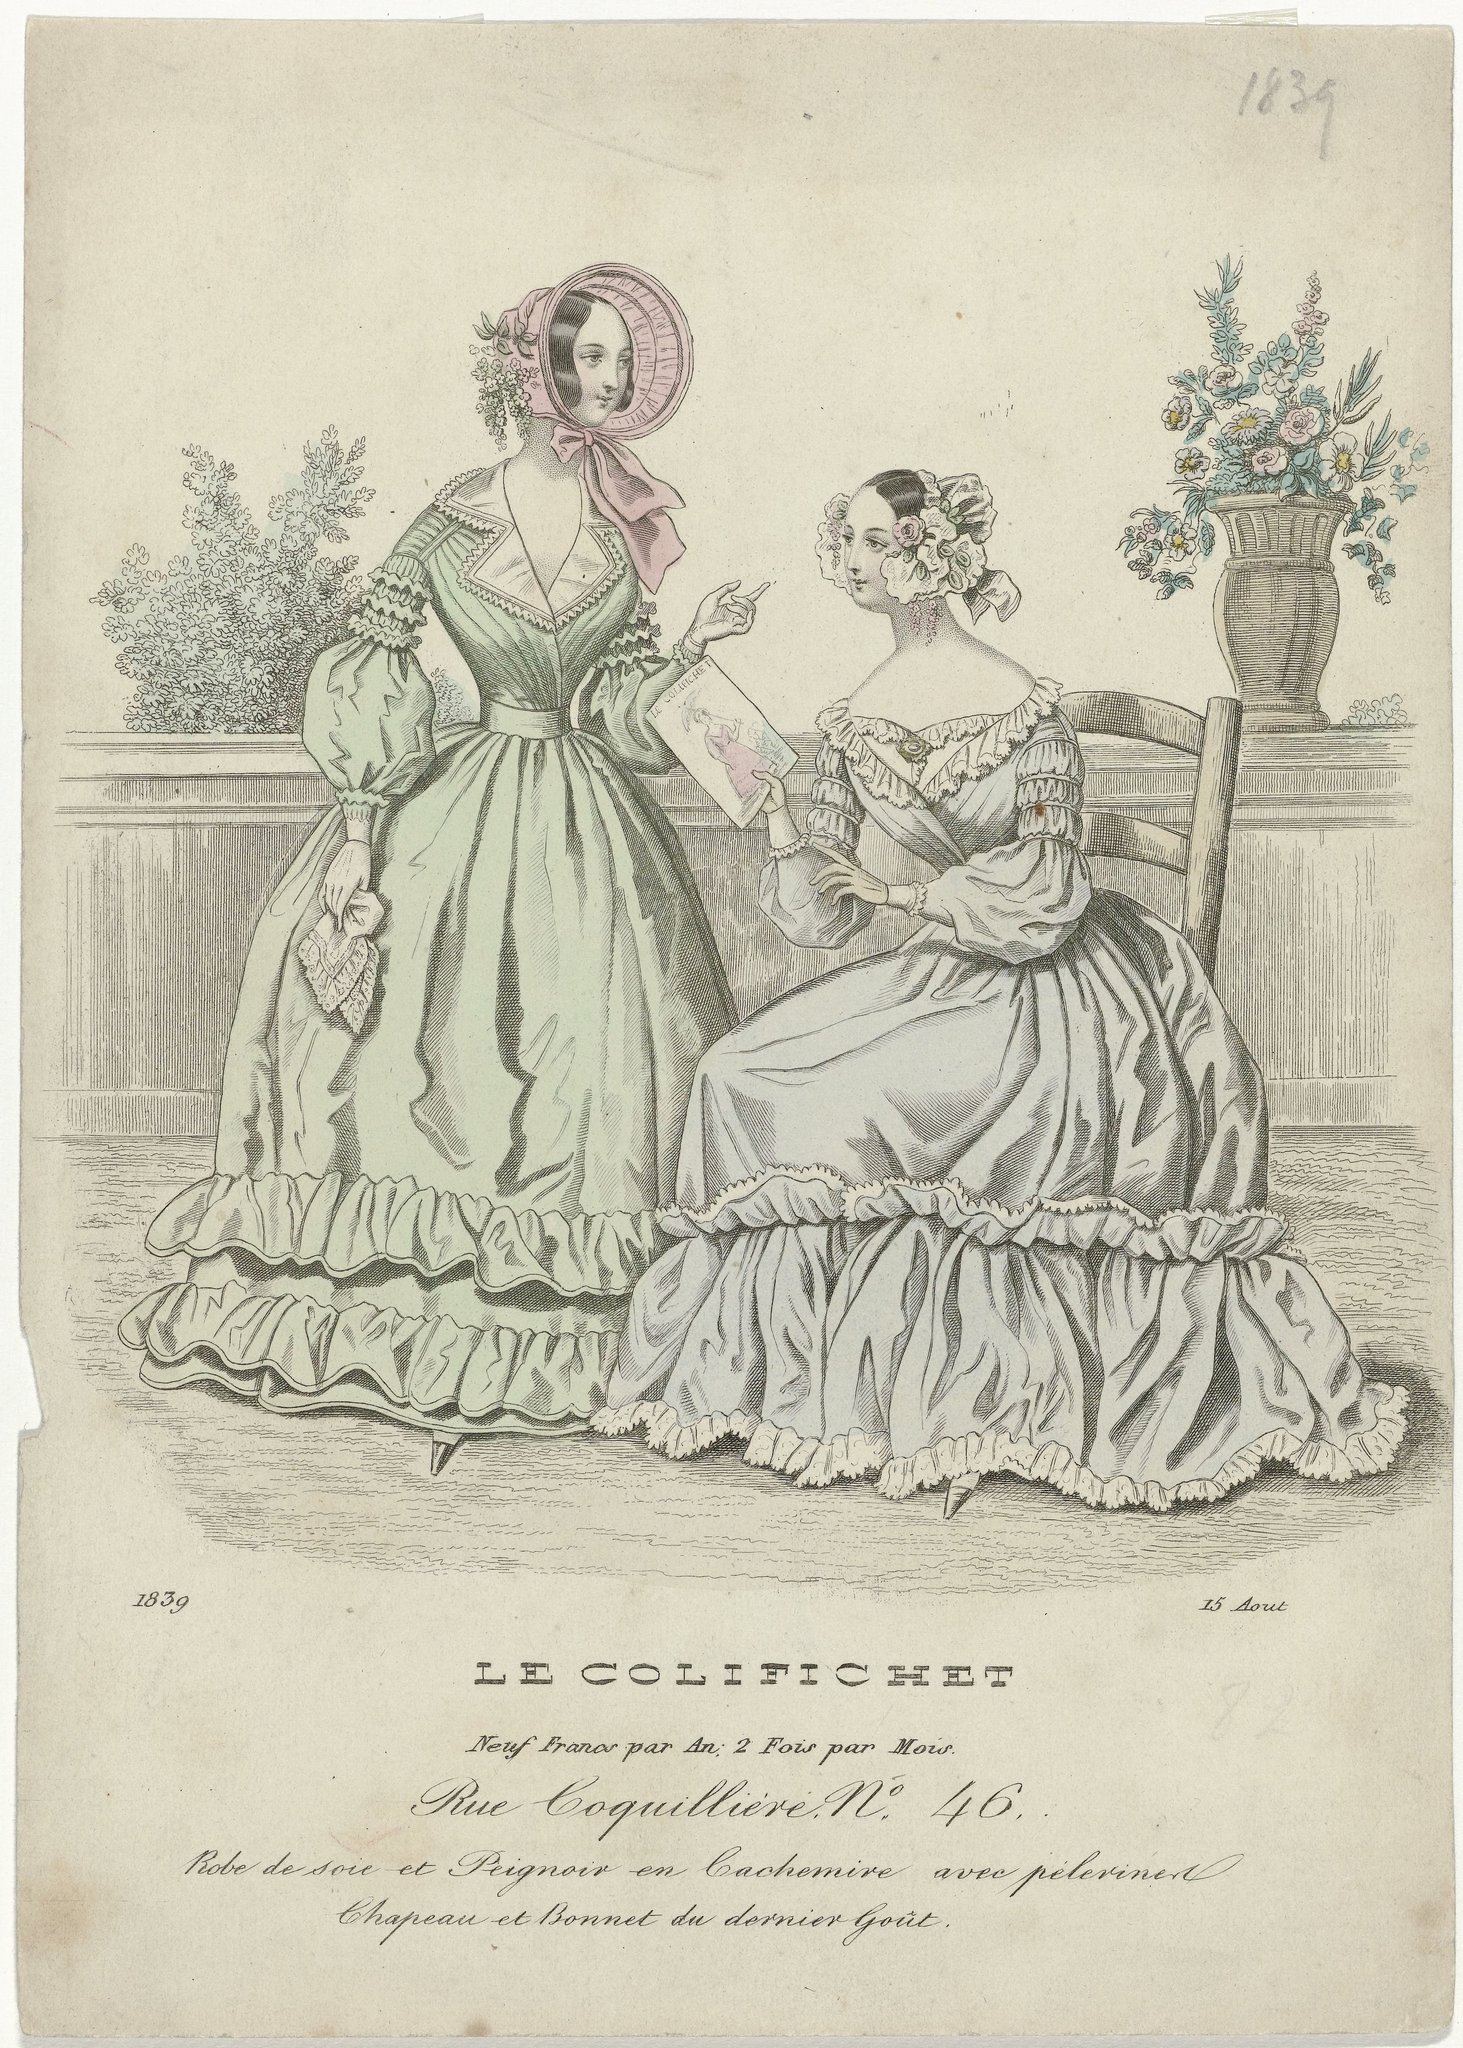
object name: fashion print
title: Le Colifichet, 15 août 1839 : Robe de soie et Peignoior (...)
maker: Anonymous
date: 1839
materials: paper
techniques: engraving, hand coloring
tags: handkerchief (+ women's clothes), brooch, agraffe, clasp (+ women's clothes), clothing for the upper part of the body (pelerine) (+ women's clothes), book in which illustrations are essential, coat (housecoat) (+ women's clothes), head-gear: cap (+ women's clothes), fashion plates, head-gear: hat (+ women's clothes), shoes, sandals (+ women's clothes), gloves, mittens, etc. (+ women's clothes), dress, gown (+ women's clothes)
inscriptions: address: ‘Rue Coquilliére, No. 46.’, title: ‘Le Colifichet / Neuf Francs par An: 2 fois par Mois.’, caption: ‘Robe de soie et Peignoir en Cachemire avec pélerines Chapeau et Bonnet du dernier Goût.’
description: Twee vrouwen, van wie één met het modetijdschrift 'Le Colifichet' in de hand. Volgens het onderschrift: japon van zijde en 'peignoir' van kasjmier met pelerines. Hoed en muts volgens de laatste mode. Prent uit het modetijdschrift Le Colifichet (1838-1843).